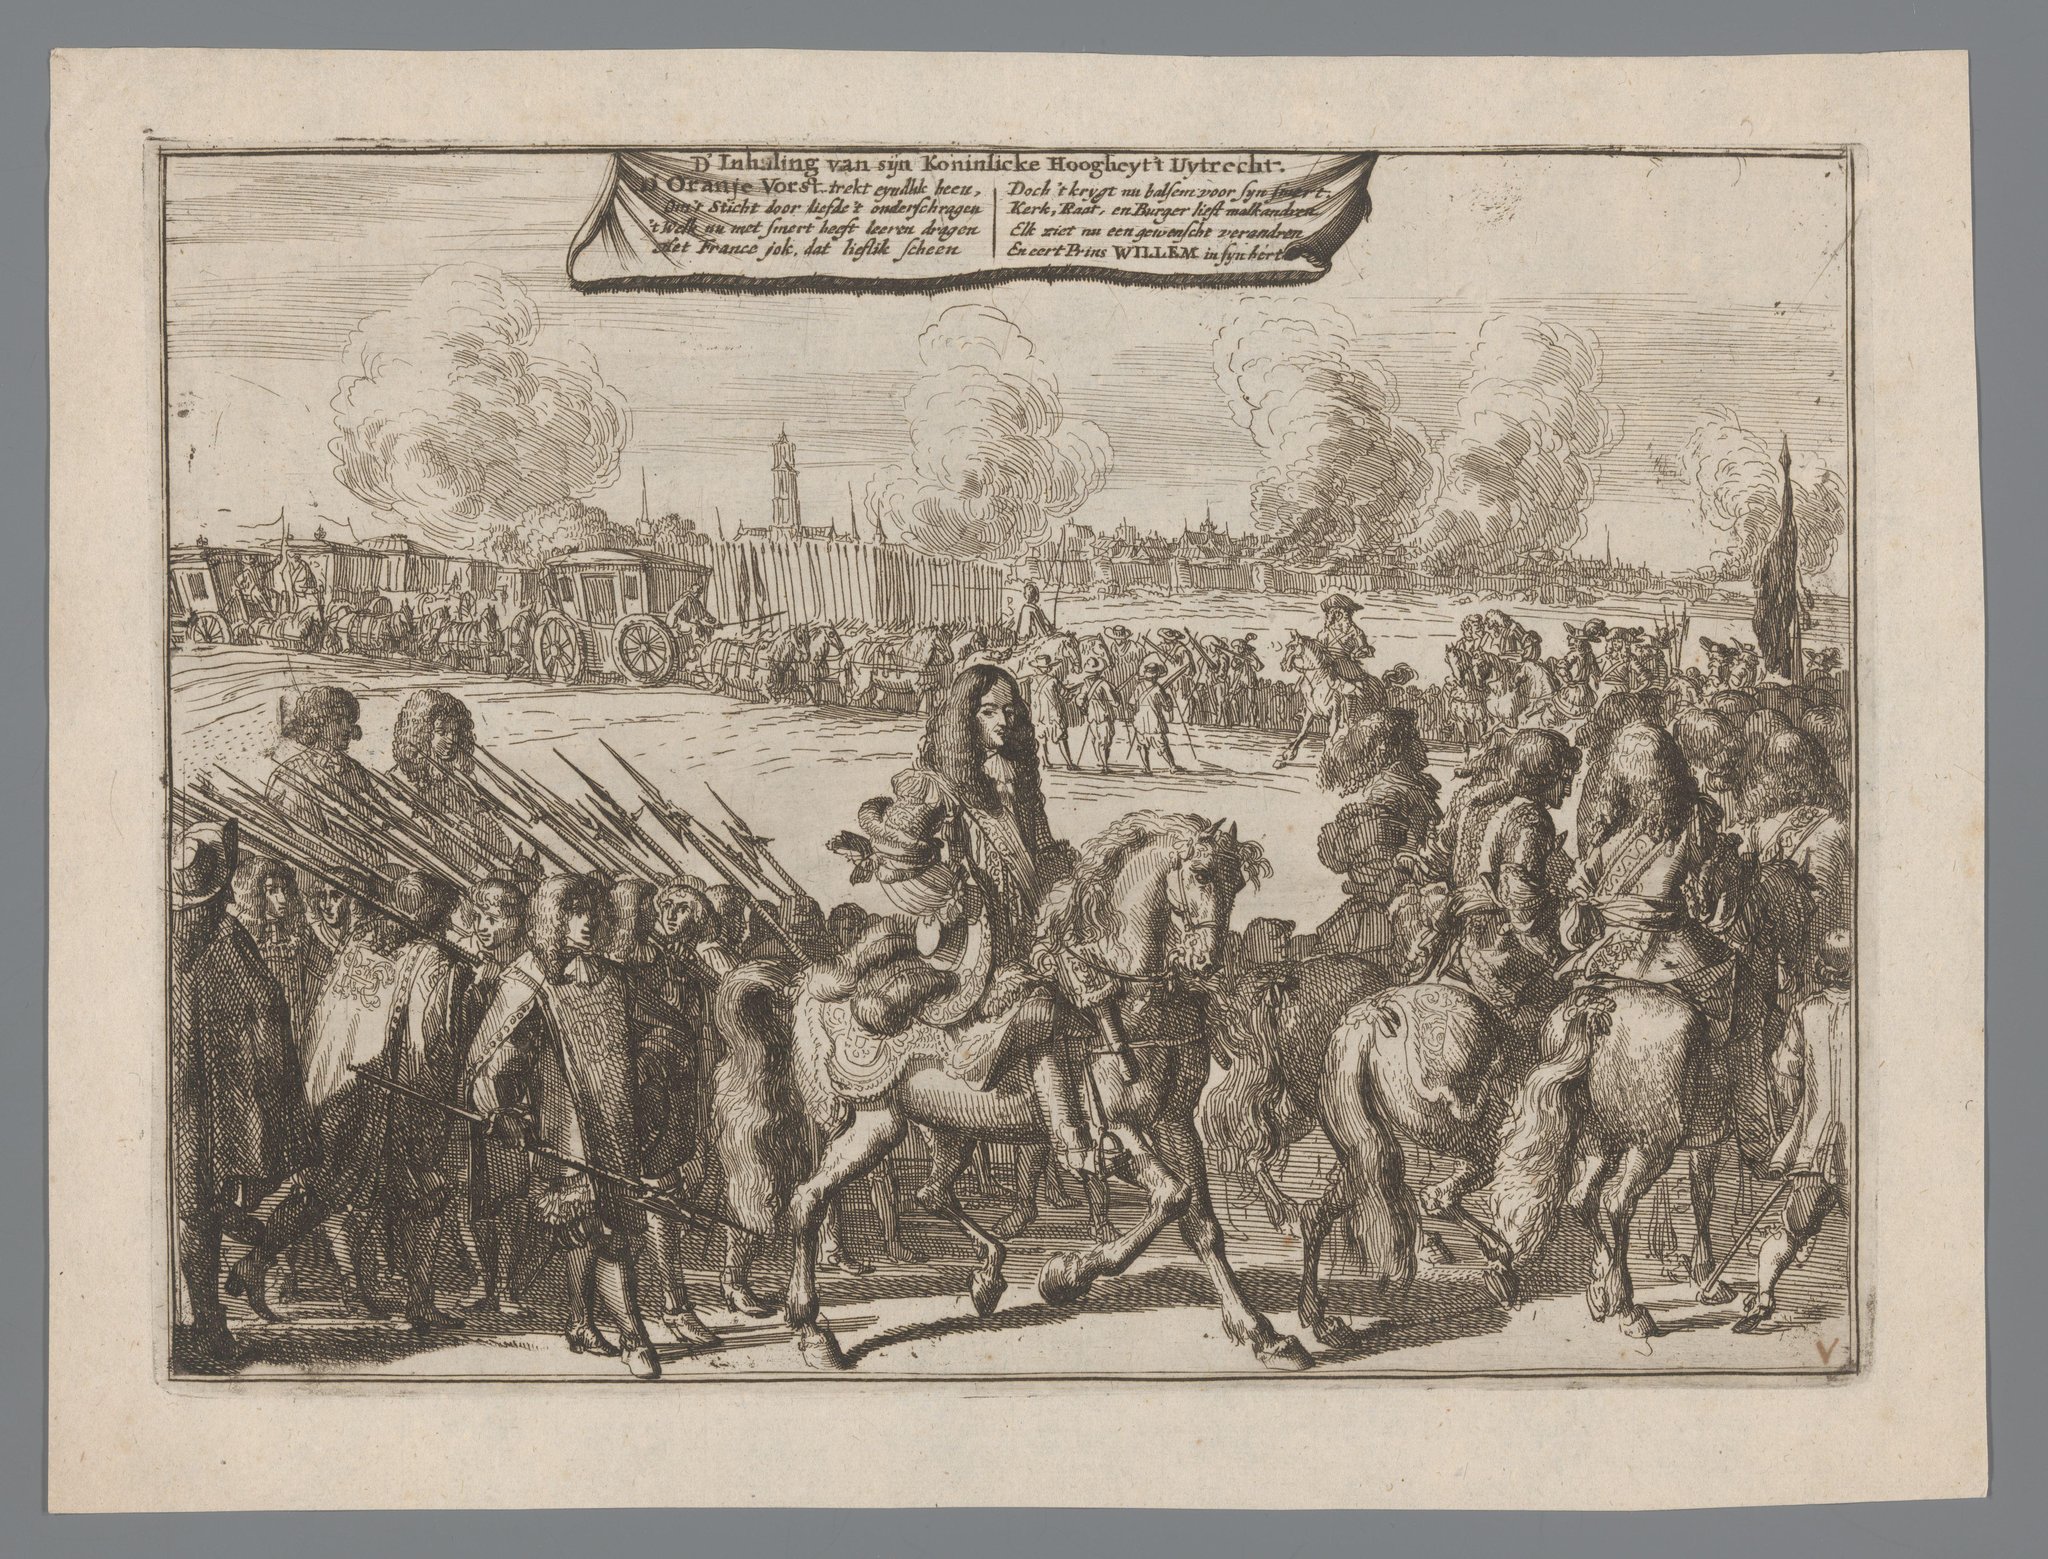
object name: print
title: Aankomst van prins Willem III te Utrecht in april 1674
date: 1674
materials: paper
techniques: etching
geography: amsterdam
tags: william iii (prince of orange and king of england, scotland, and ireland), triumphal entry and public reception, pageant, 'entrée solennelle', 'joyeuse entrée', utrecht, rampjaar (disaster year)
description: De aankomst van prins Willem III te Utrecht in april 1674. De prins centraal te paard te midden van ruiters en voetsoldaten. Op de achtergrond de stad Utrecht. Bovenaan een doek met de titel en twee vierregelige verzen in het Nederlands. Vijfde prent in een reeks van vijf prenten over de gebeurtenissen voorgevallen in Utrecht over de periode 1672-74.